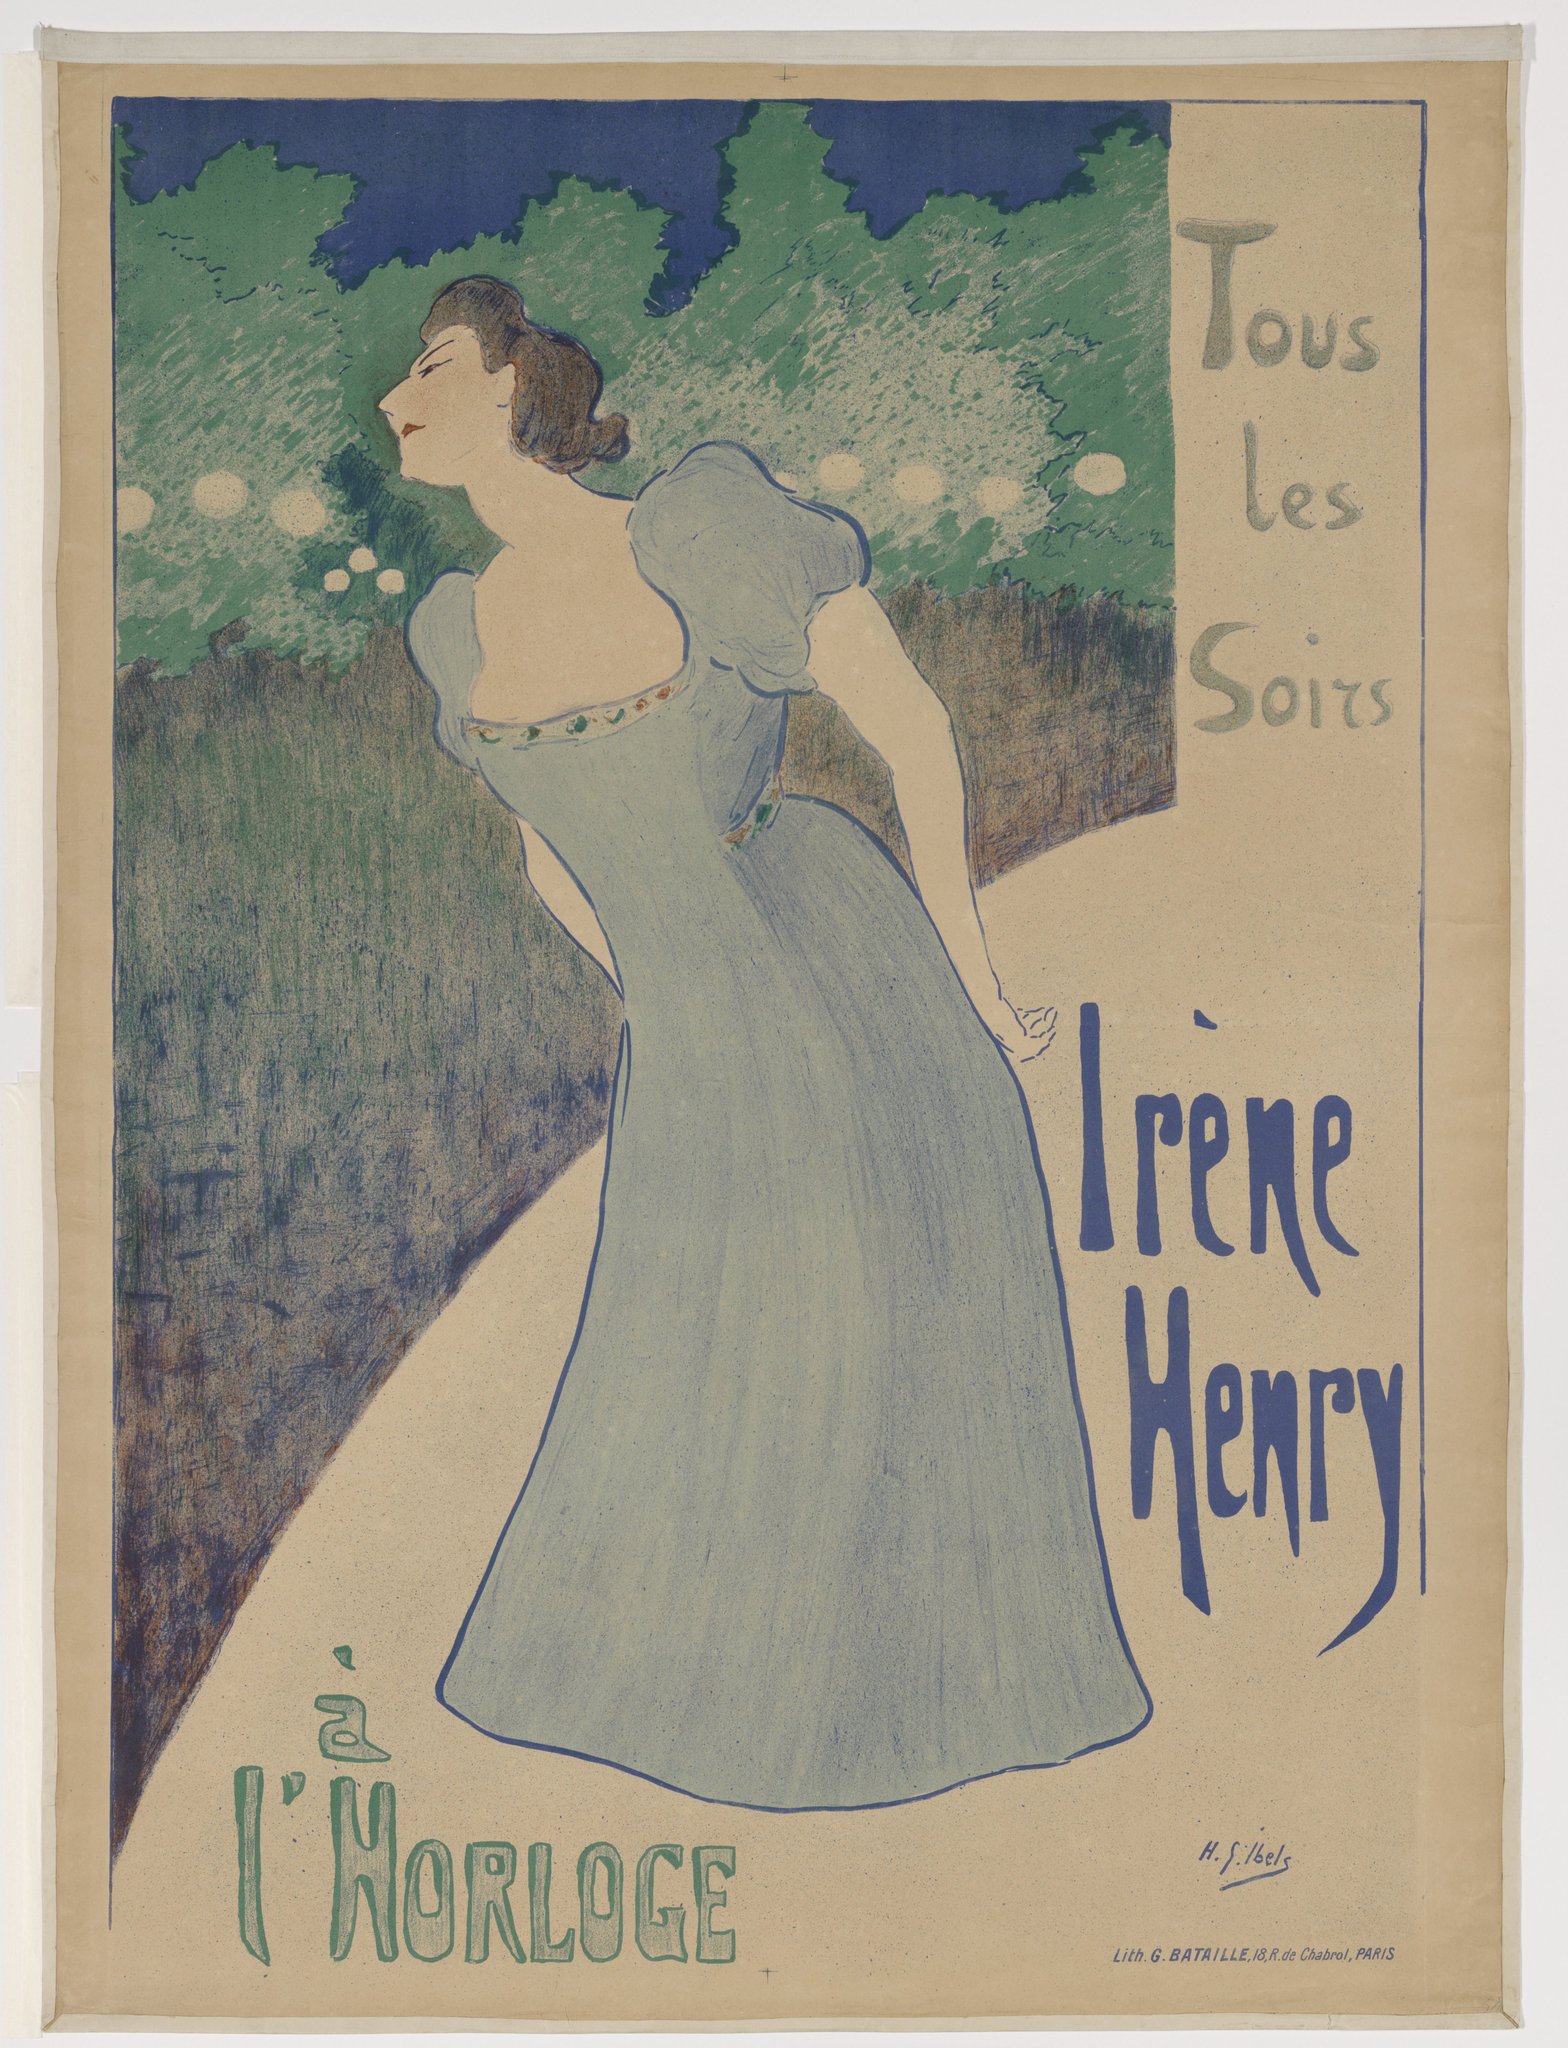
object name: poster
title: Reclamebiljet: Irène Henry à l'Horloge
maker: henri gabriel ibels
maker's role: print maker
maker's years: 1867-1936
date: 1877-1912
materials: paper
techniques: lithograph